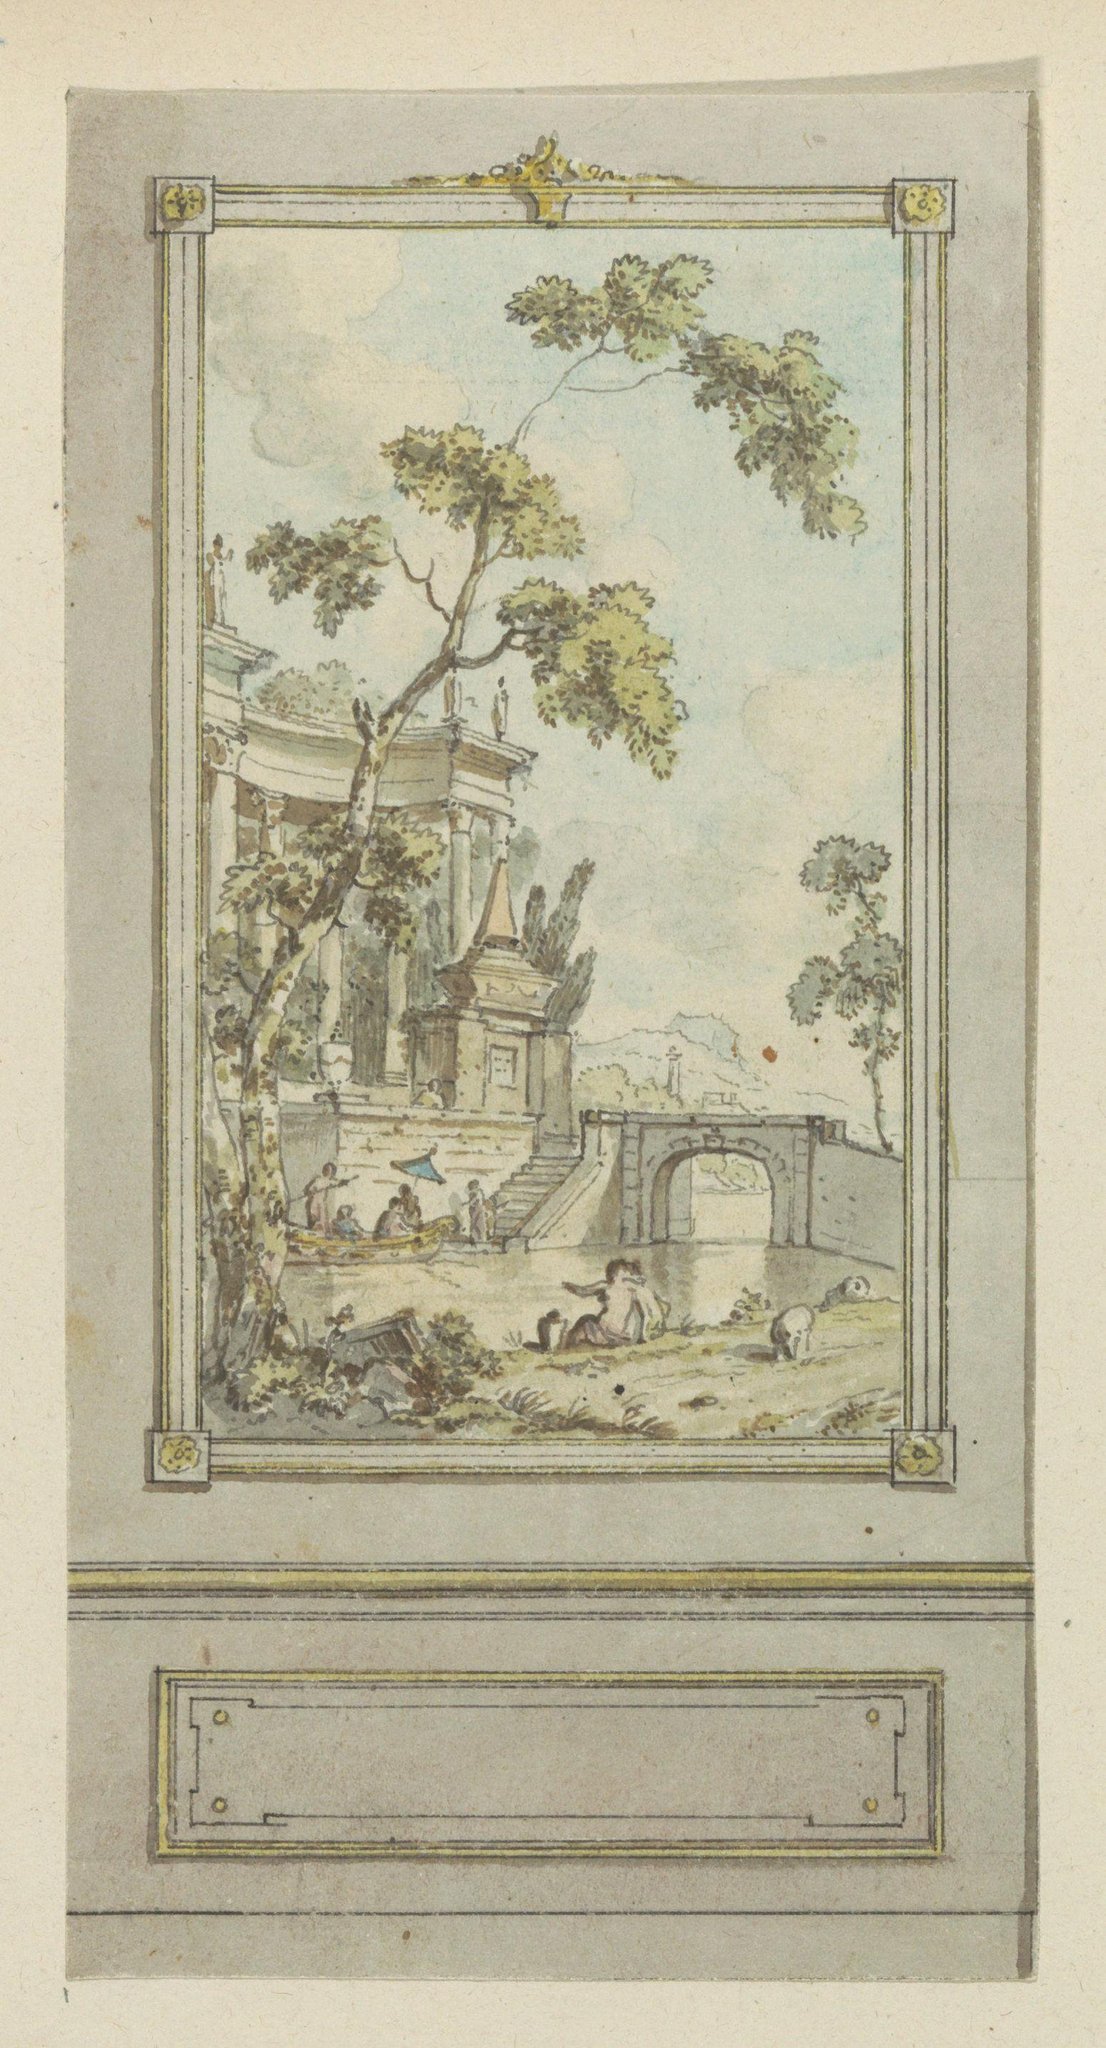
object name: drawing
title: Ontwerptekening voor een kamerwand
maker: jurriaan andriessen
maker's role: draughtsman, painter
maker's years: 1742-1819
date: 1760-1819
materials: paint, paper, pencil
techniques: brush, pen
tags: wall-covering, pastorals, arcadian scenes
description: Met een arcadisch landschap. Tekening maakt deel uit van een album.